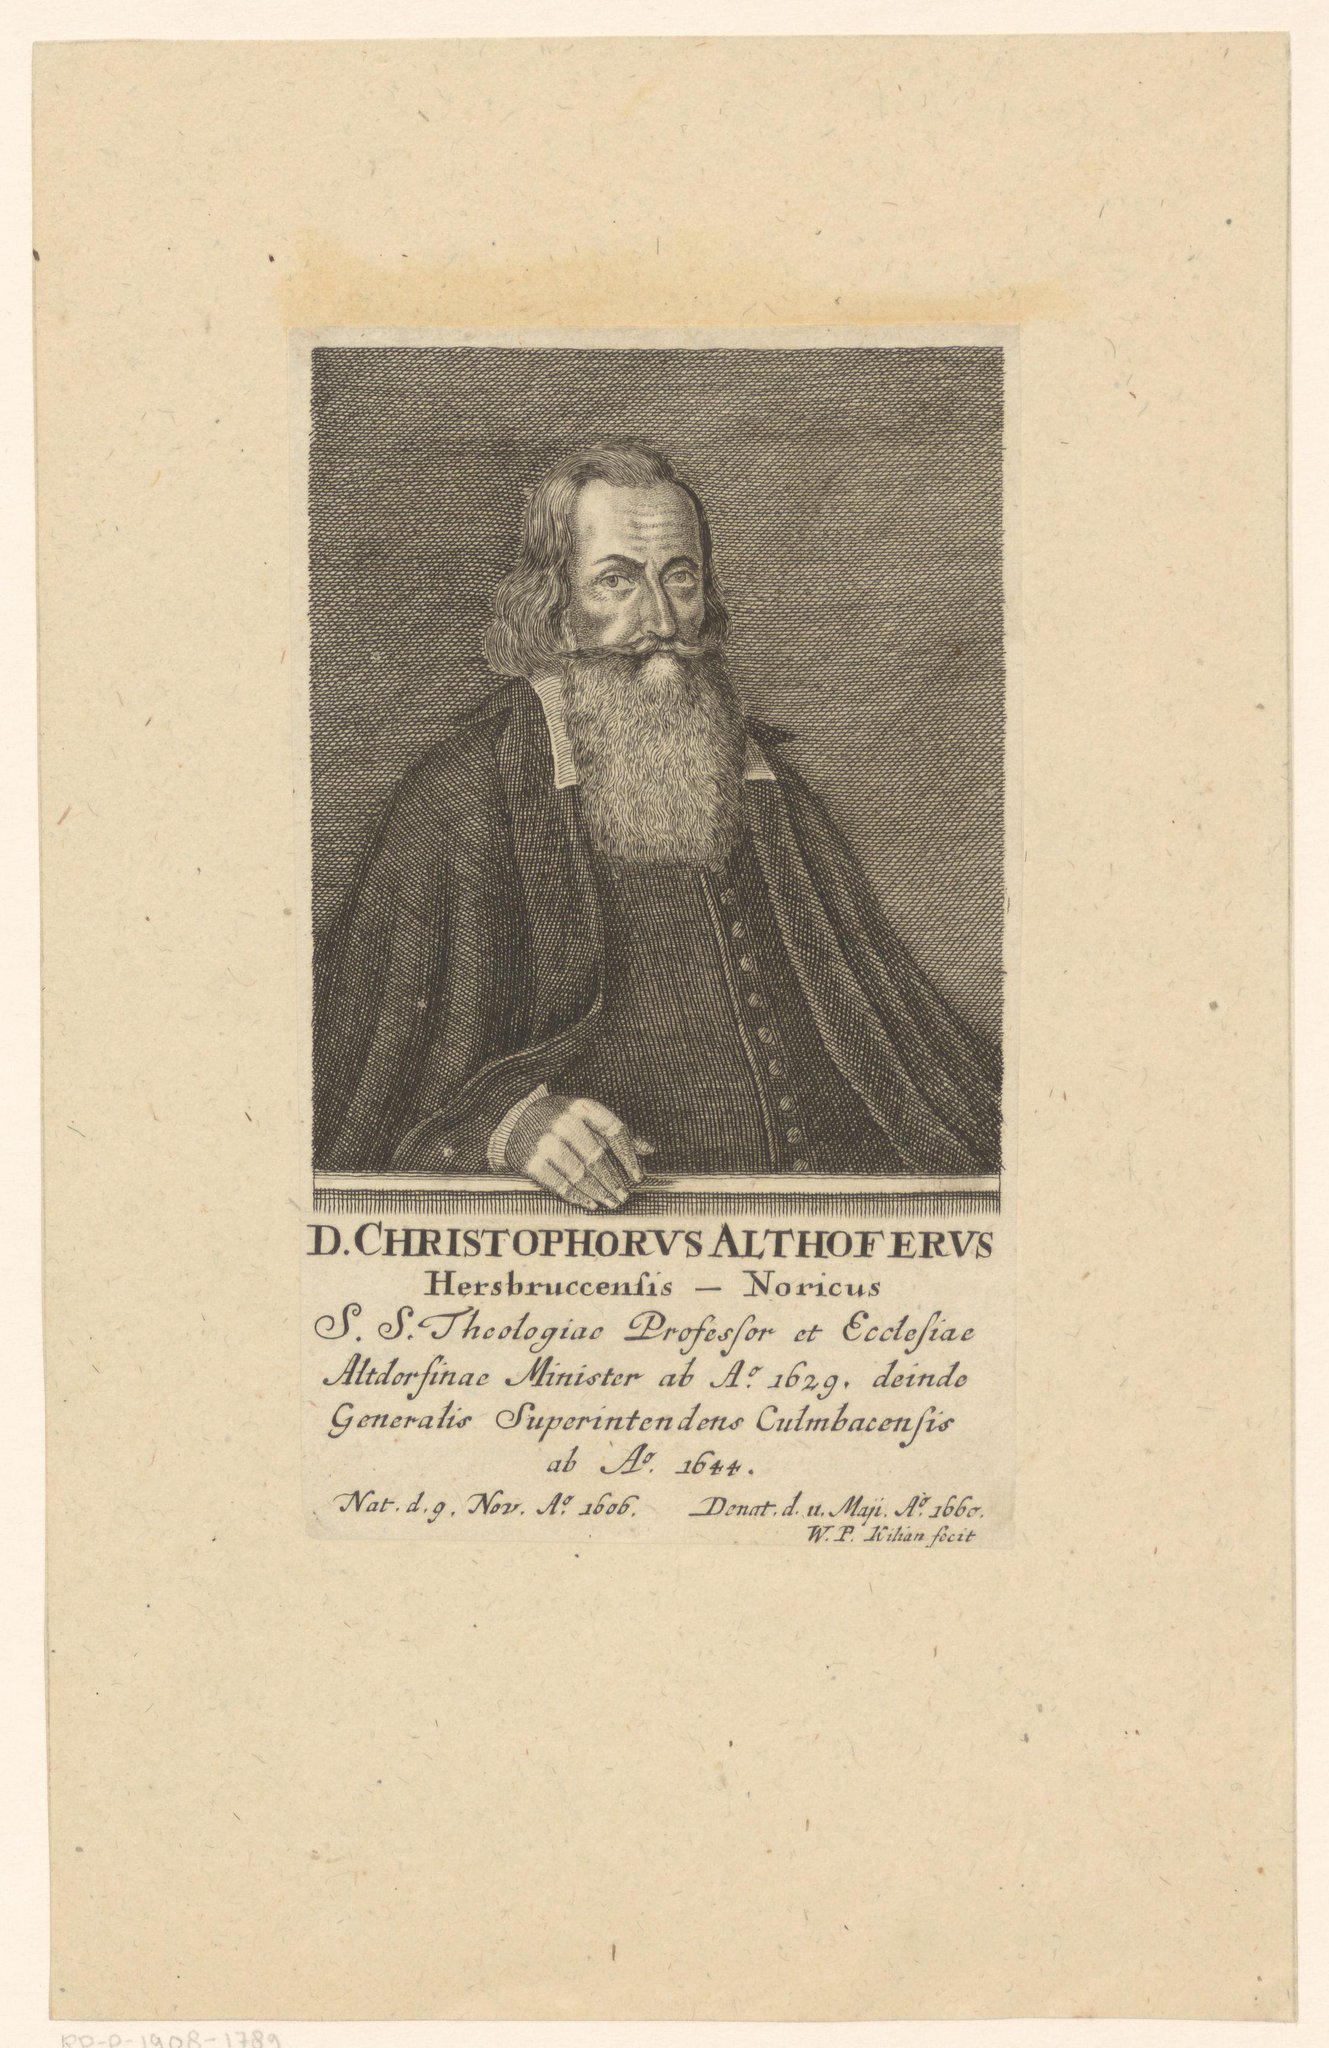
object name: print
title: Portret van Christoph Althofer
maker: wolfgang philipp kilian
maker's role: artist, draughtsman, print maker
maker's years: 1654-1732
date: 1669-1732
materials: paper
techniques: engraving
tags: theologian, further education (+ portrait of teacher, professor), historical persons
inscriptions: collector's mark: Lugt 2228